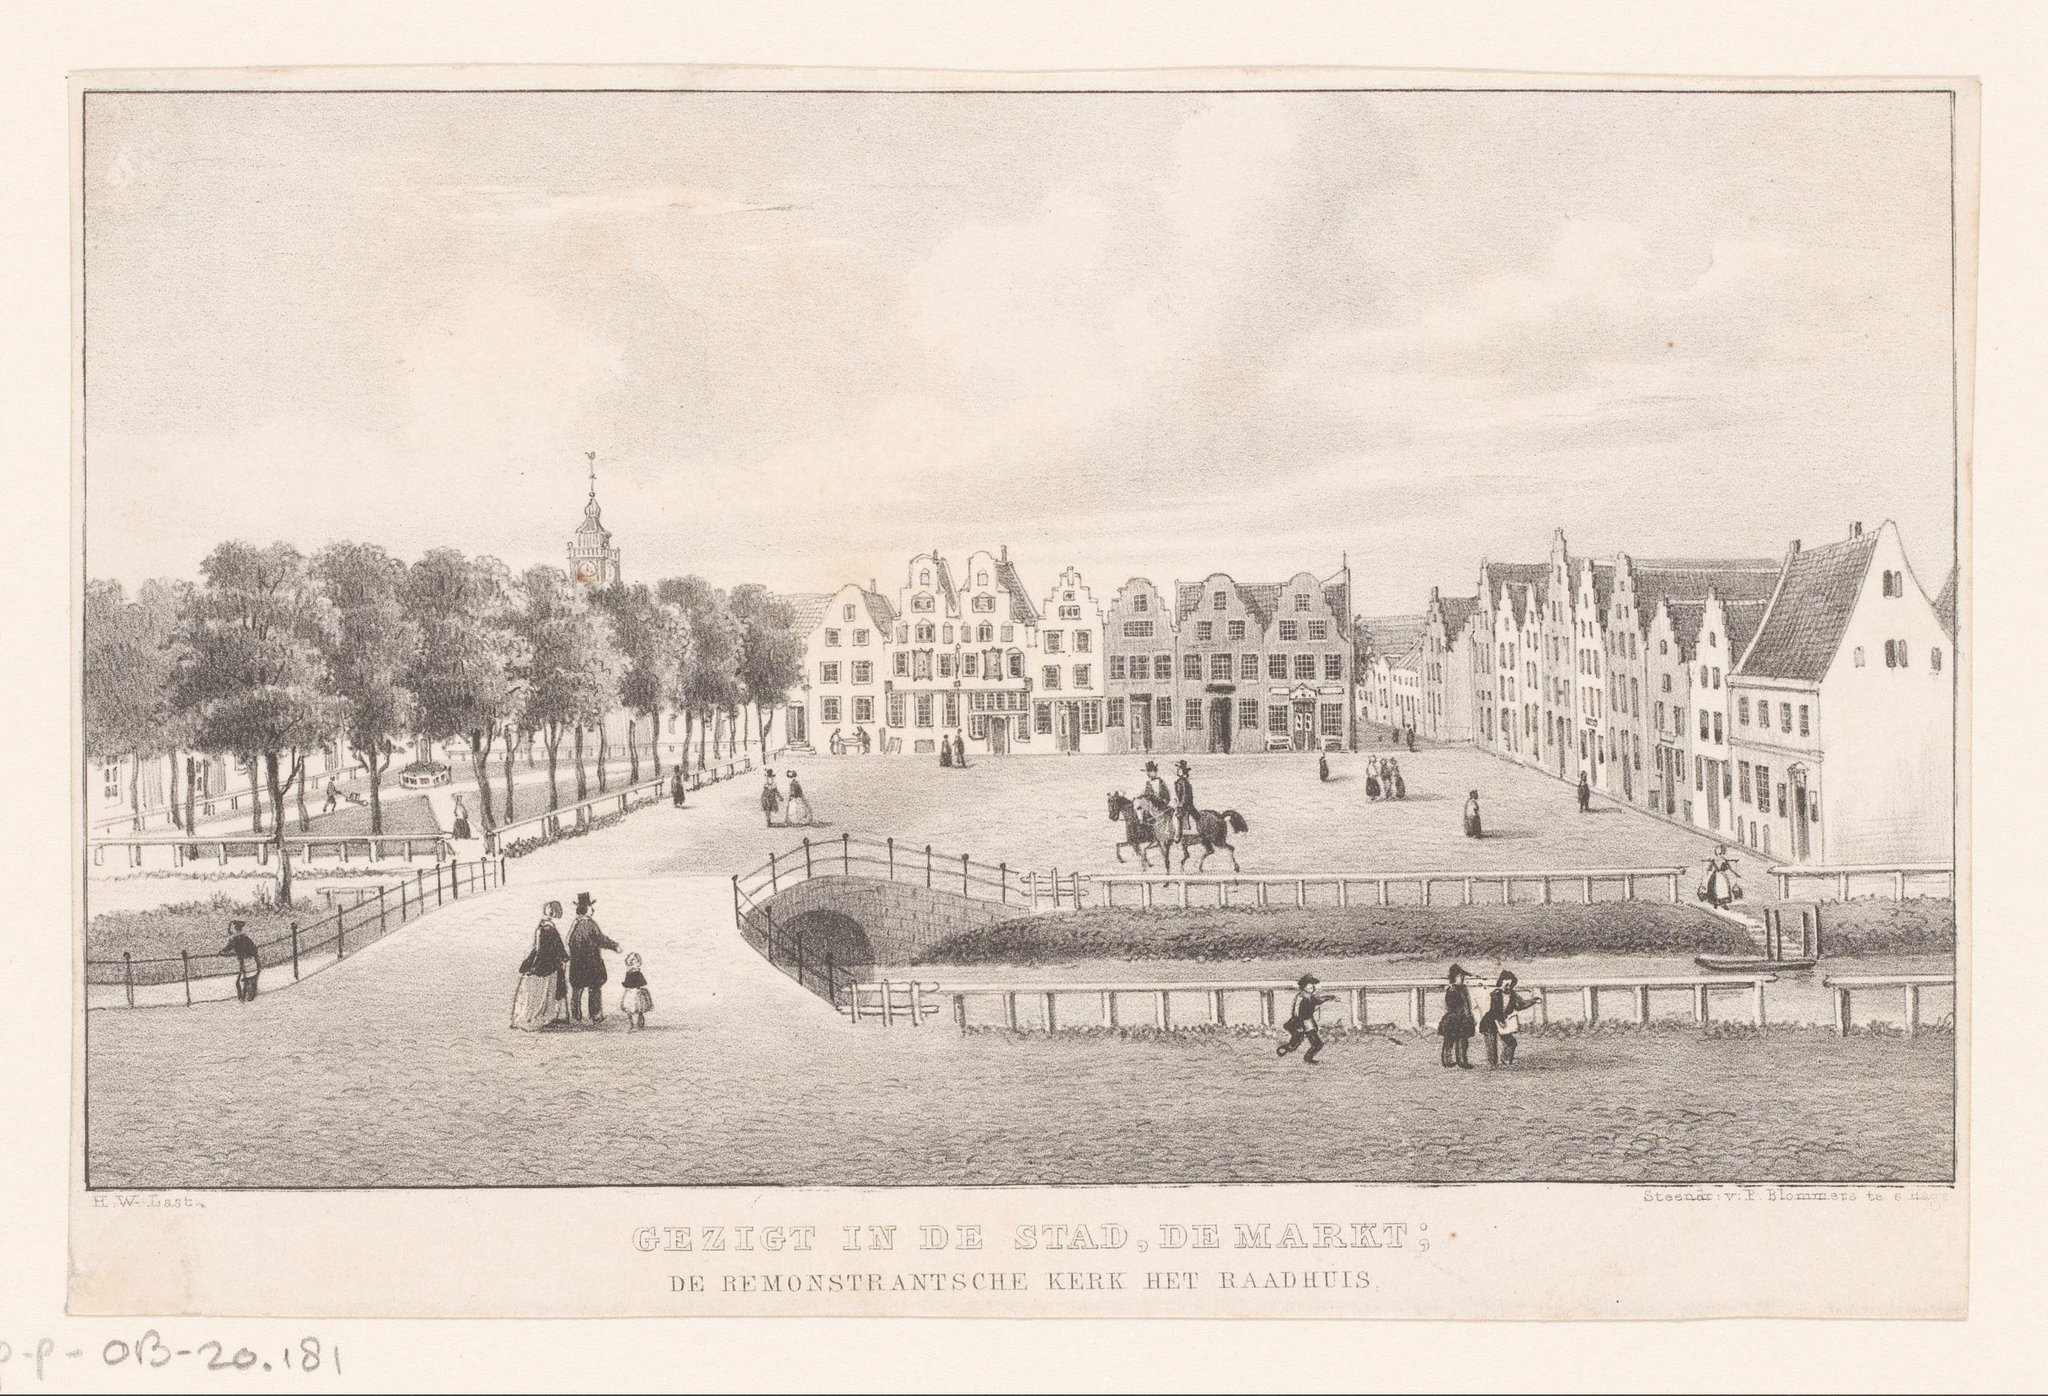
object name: print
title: Gezigt in de stad, de markt; de Remonstrantsche kerk het raadhuis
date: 1842-1887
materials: paper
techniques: lithograph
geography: the hague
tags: square, place, circus, etc.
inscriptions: collector's mark: Lugt 2228